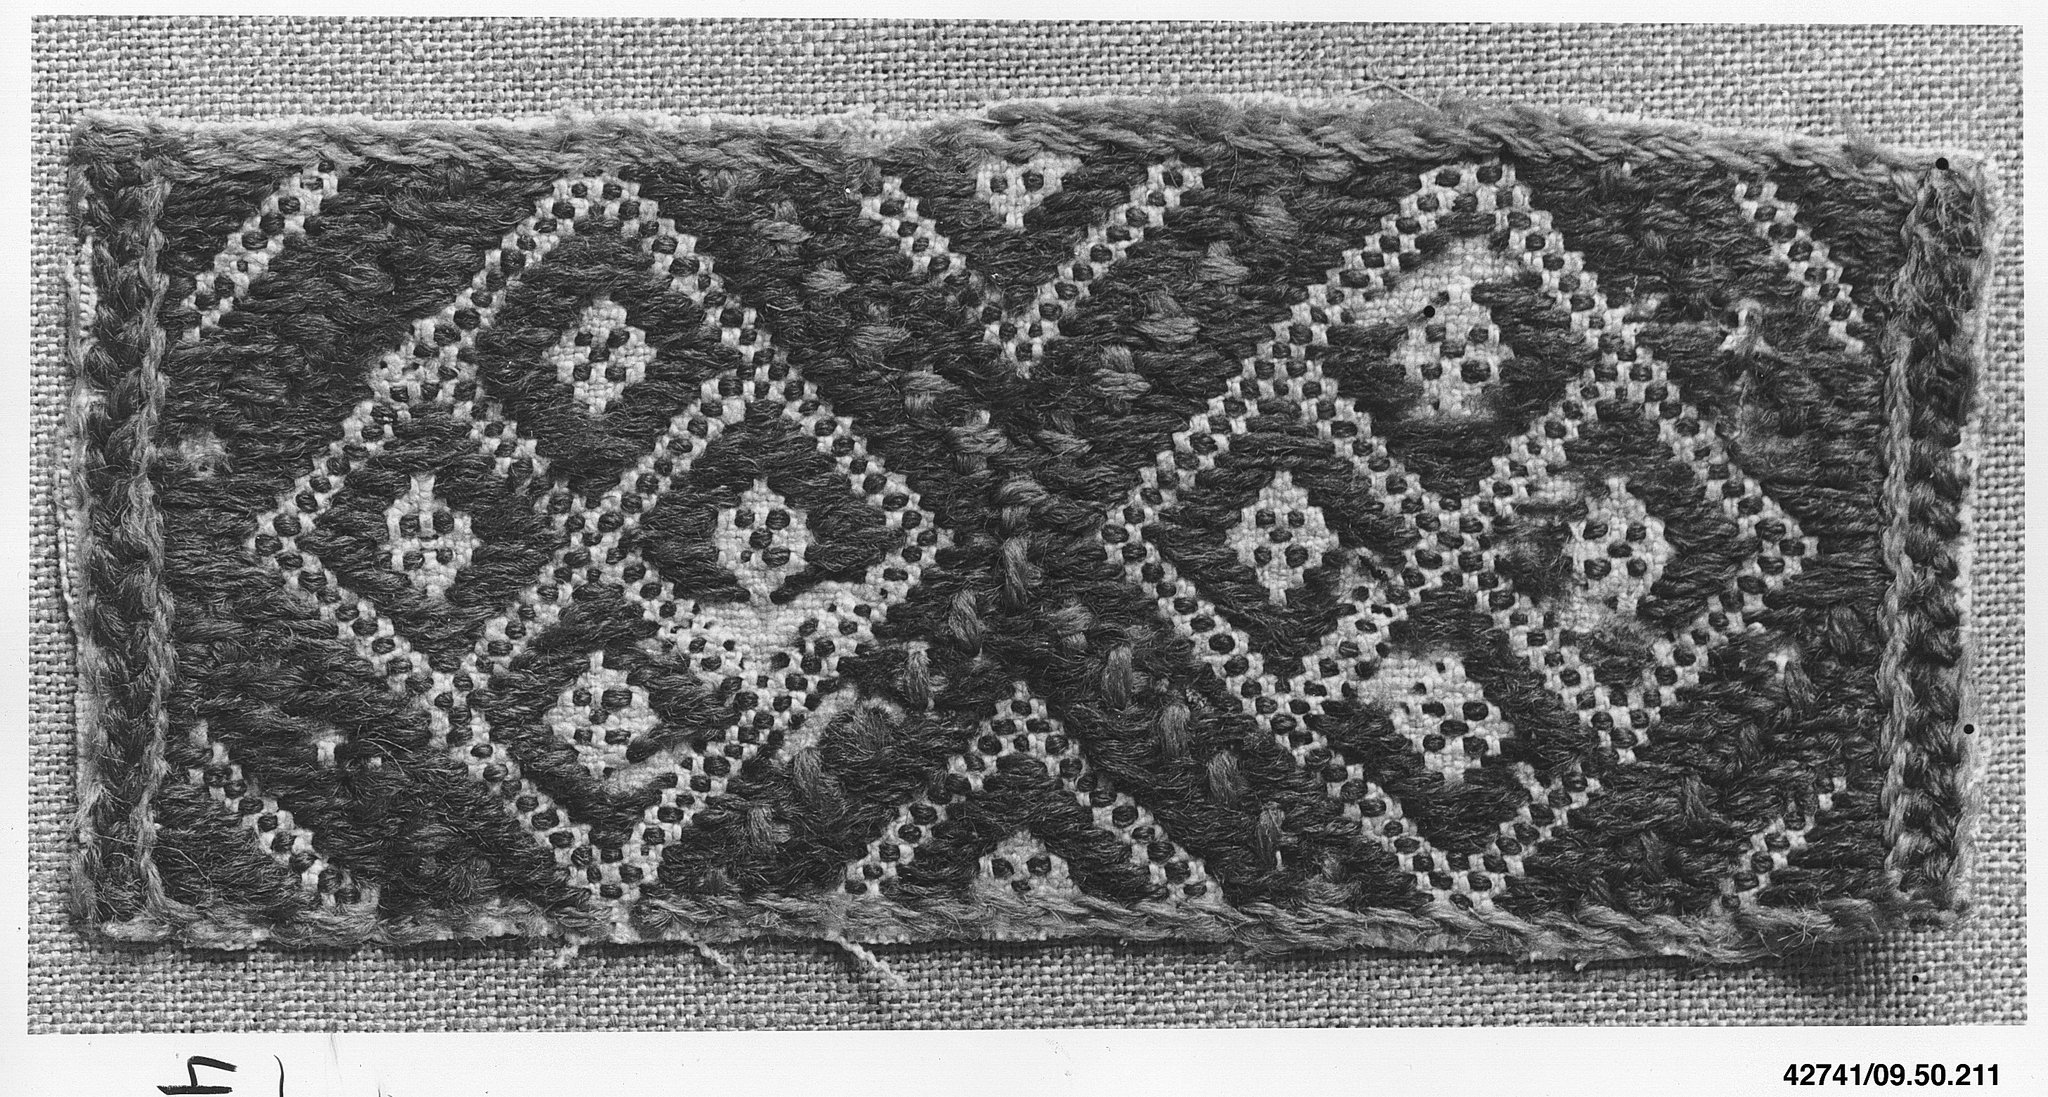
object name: blouse fragment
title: Peasant blouse fragment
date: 1701-1900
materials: canvas, wool